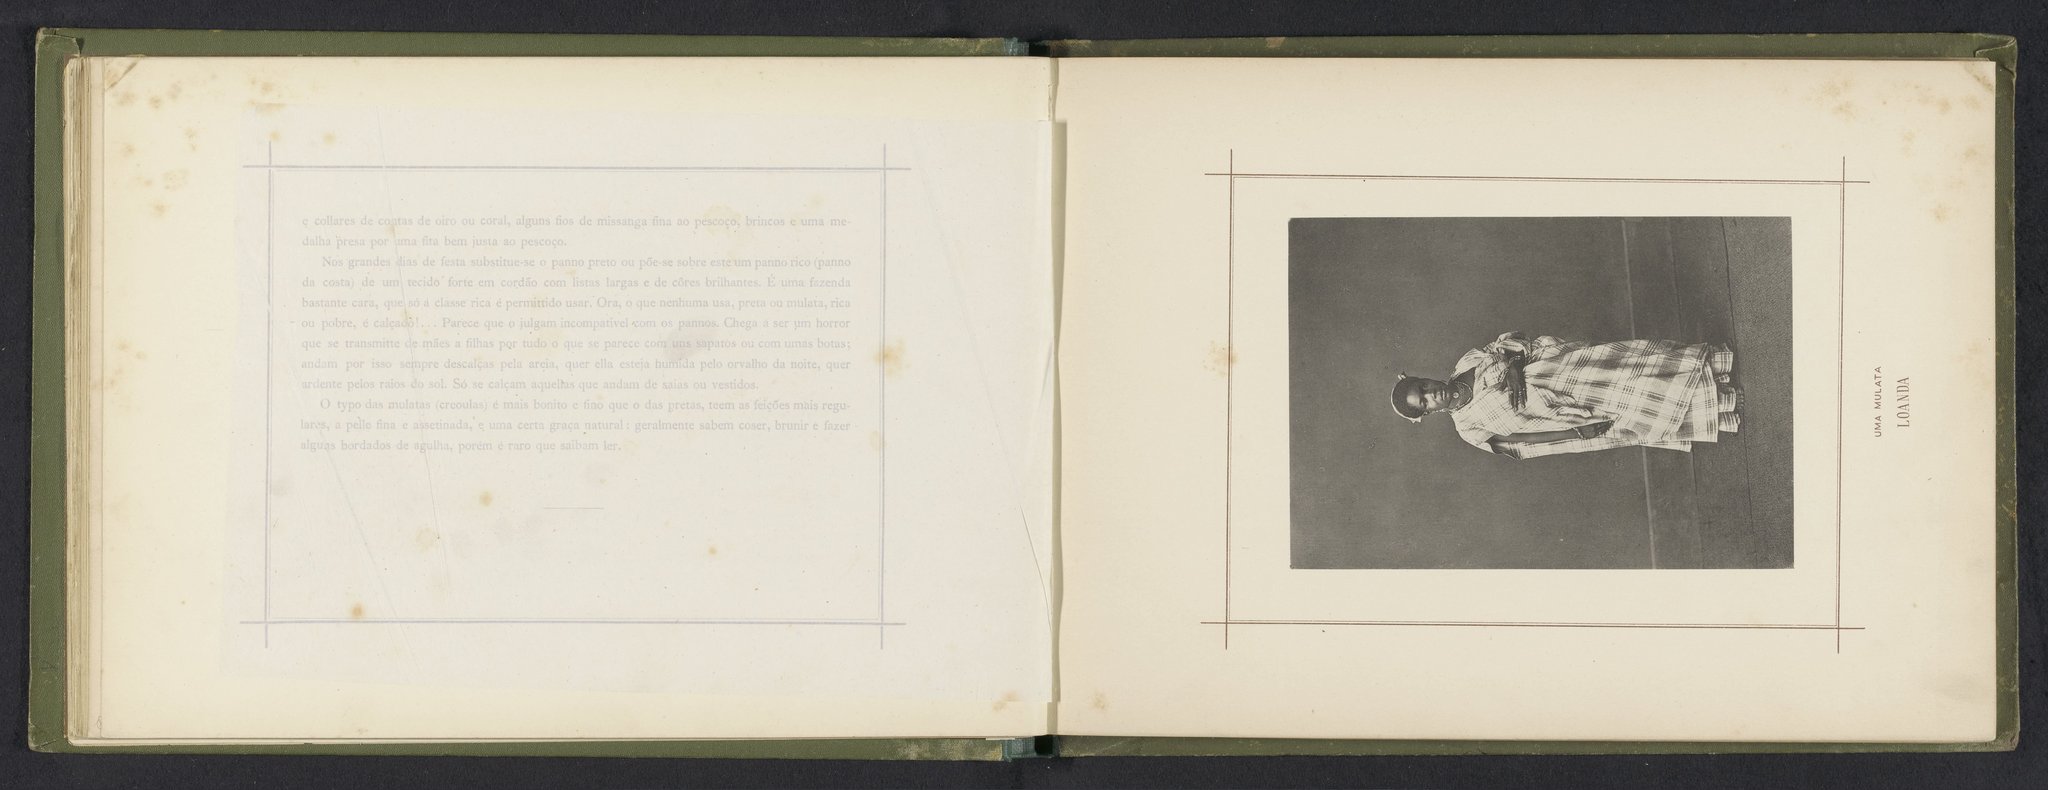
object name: page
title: Portret van een onbekende vrouw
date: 1876-1886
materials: paper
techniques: photograph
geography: luanda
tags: adult woman, historical persons not known by name - bb - woman